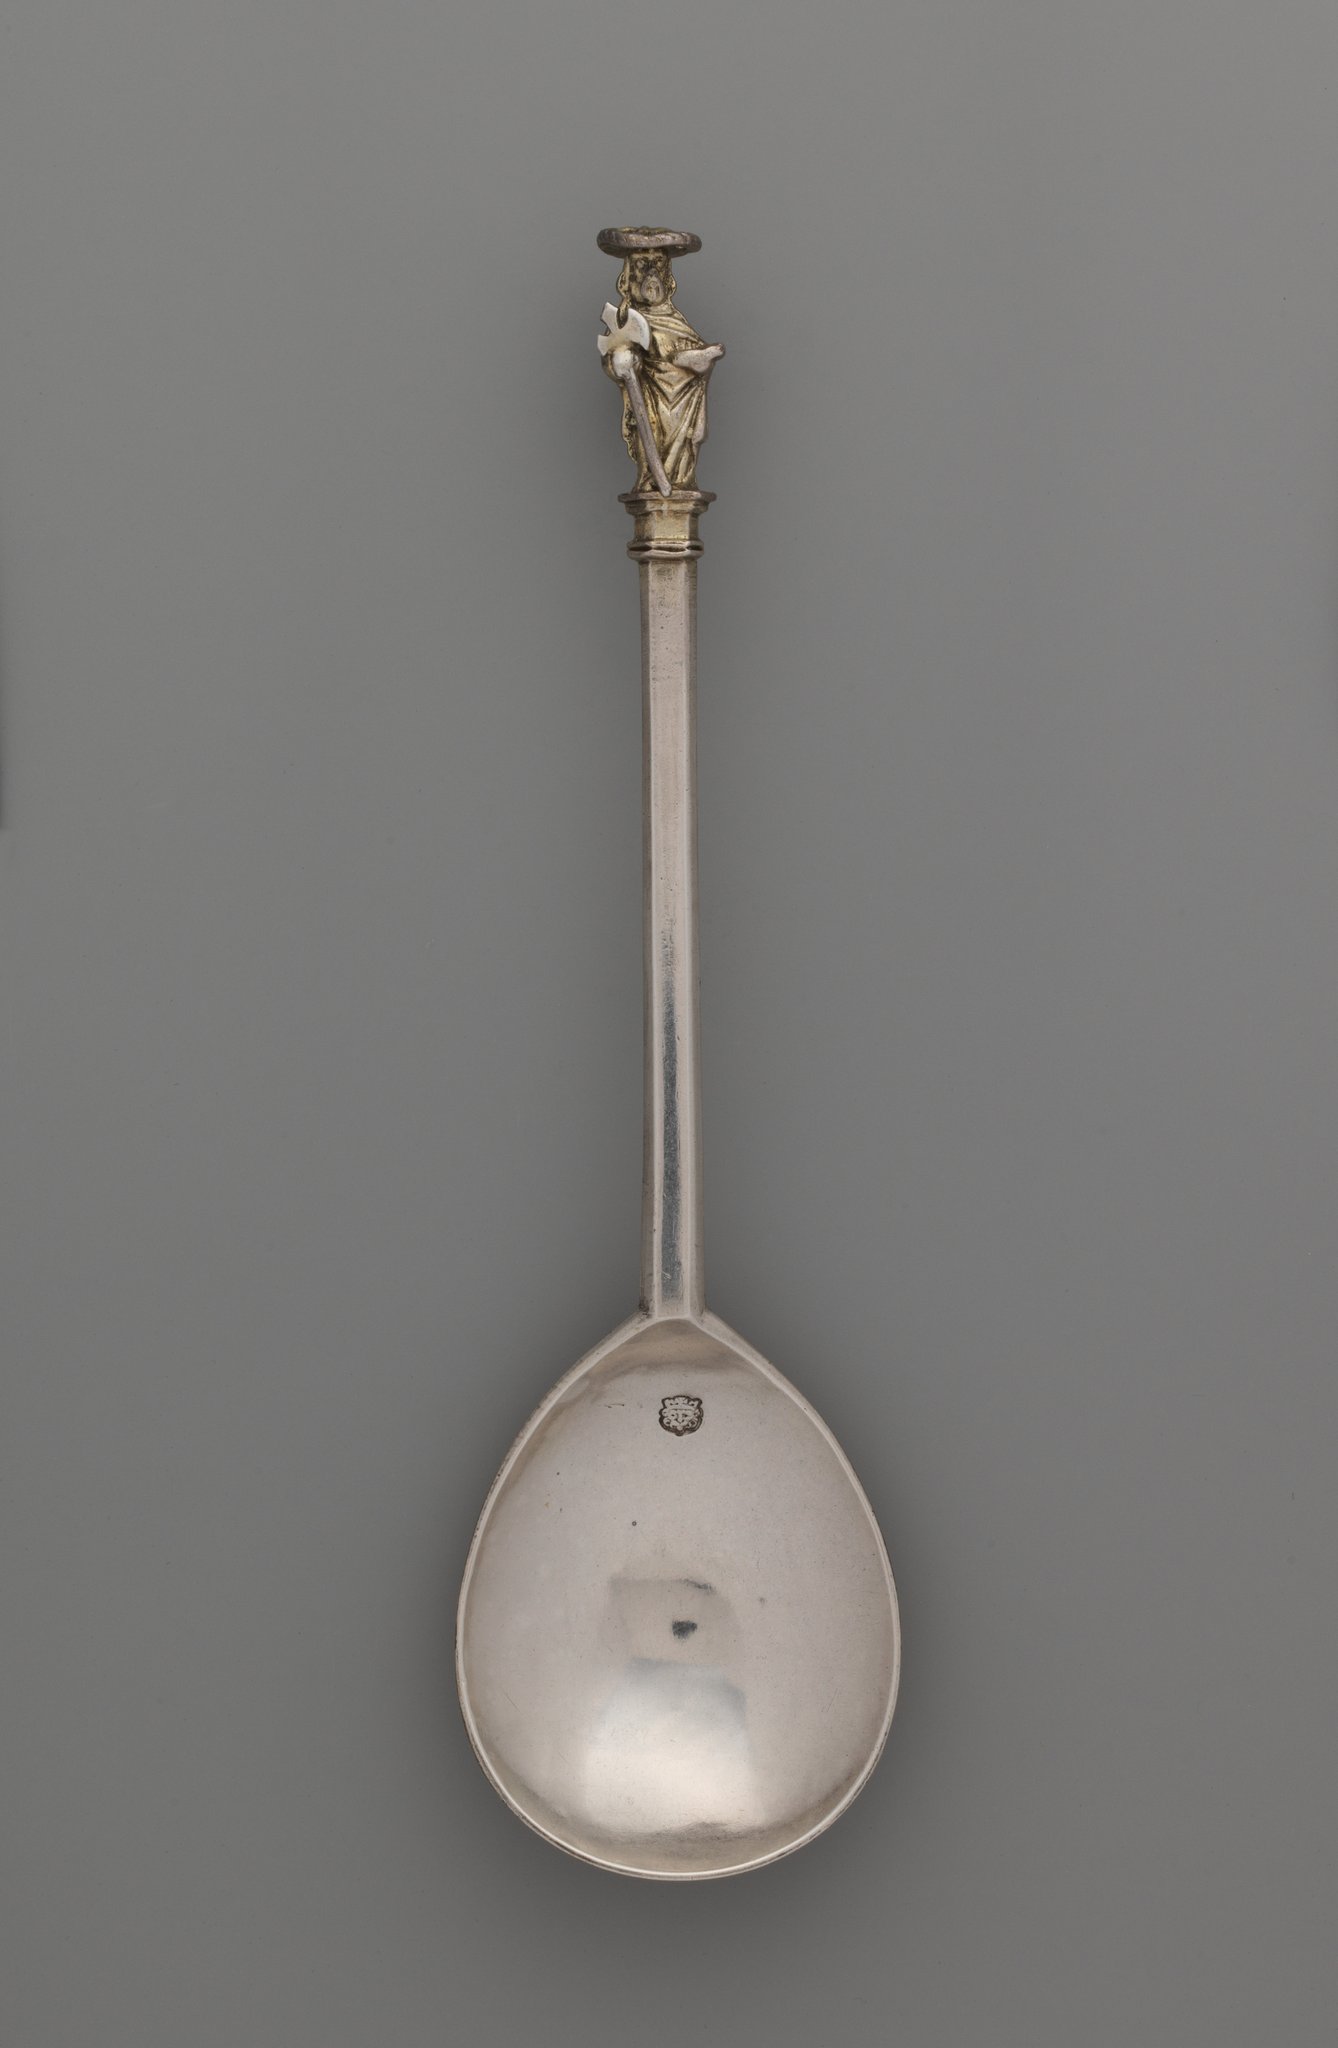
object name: apostle spoon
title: Apostle spoon: St. Matthias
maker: william cawdell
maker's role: maker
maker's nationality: british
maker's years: 1560-1625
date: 1592-1593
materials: silver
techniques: gilding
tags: saints